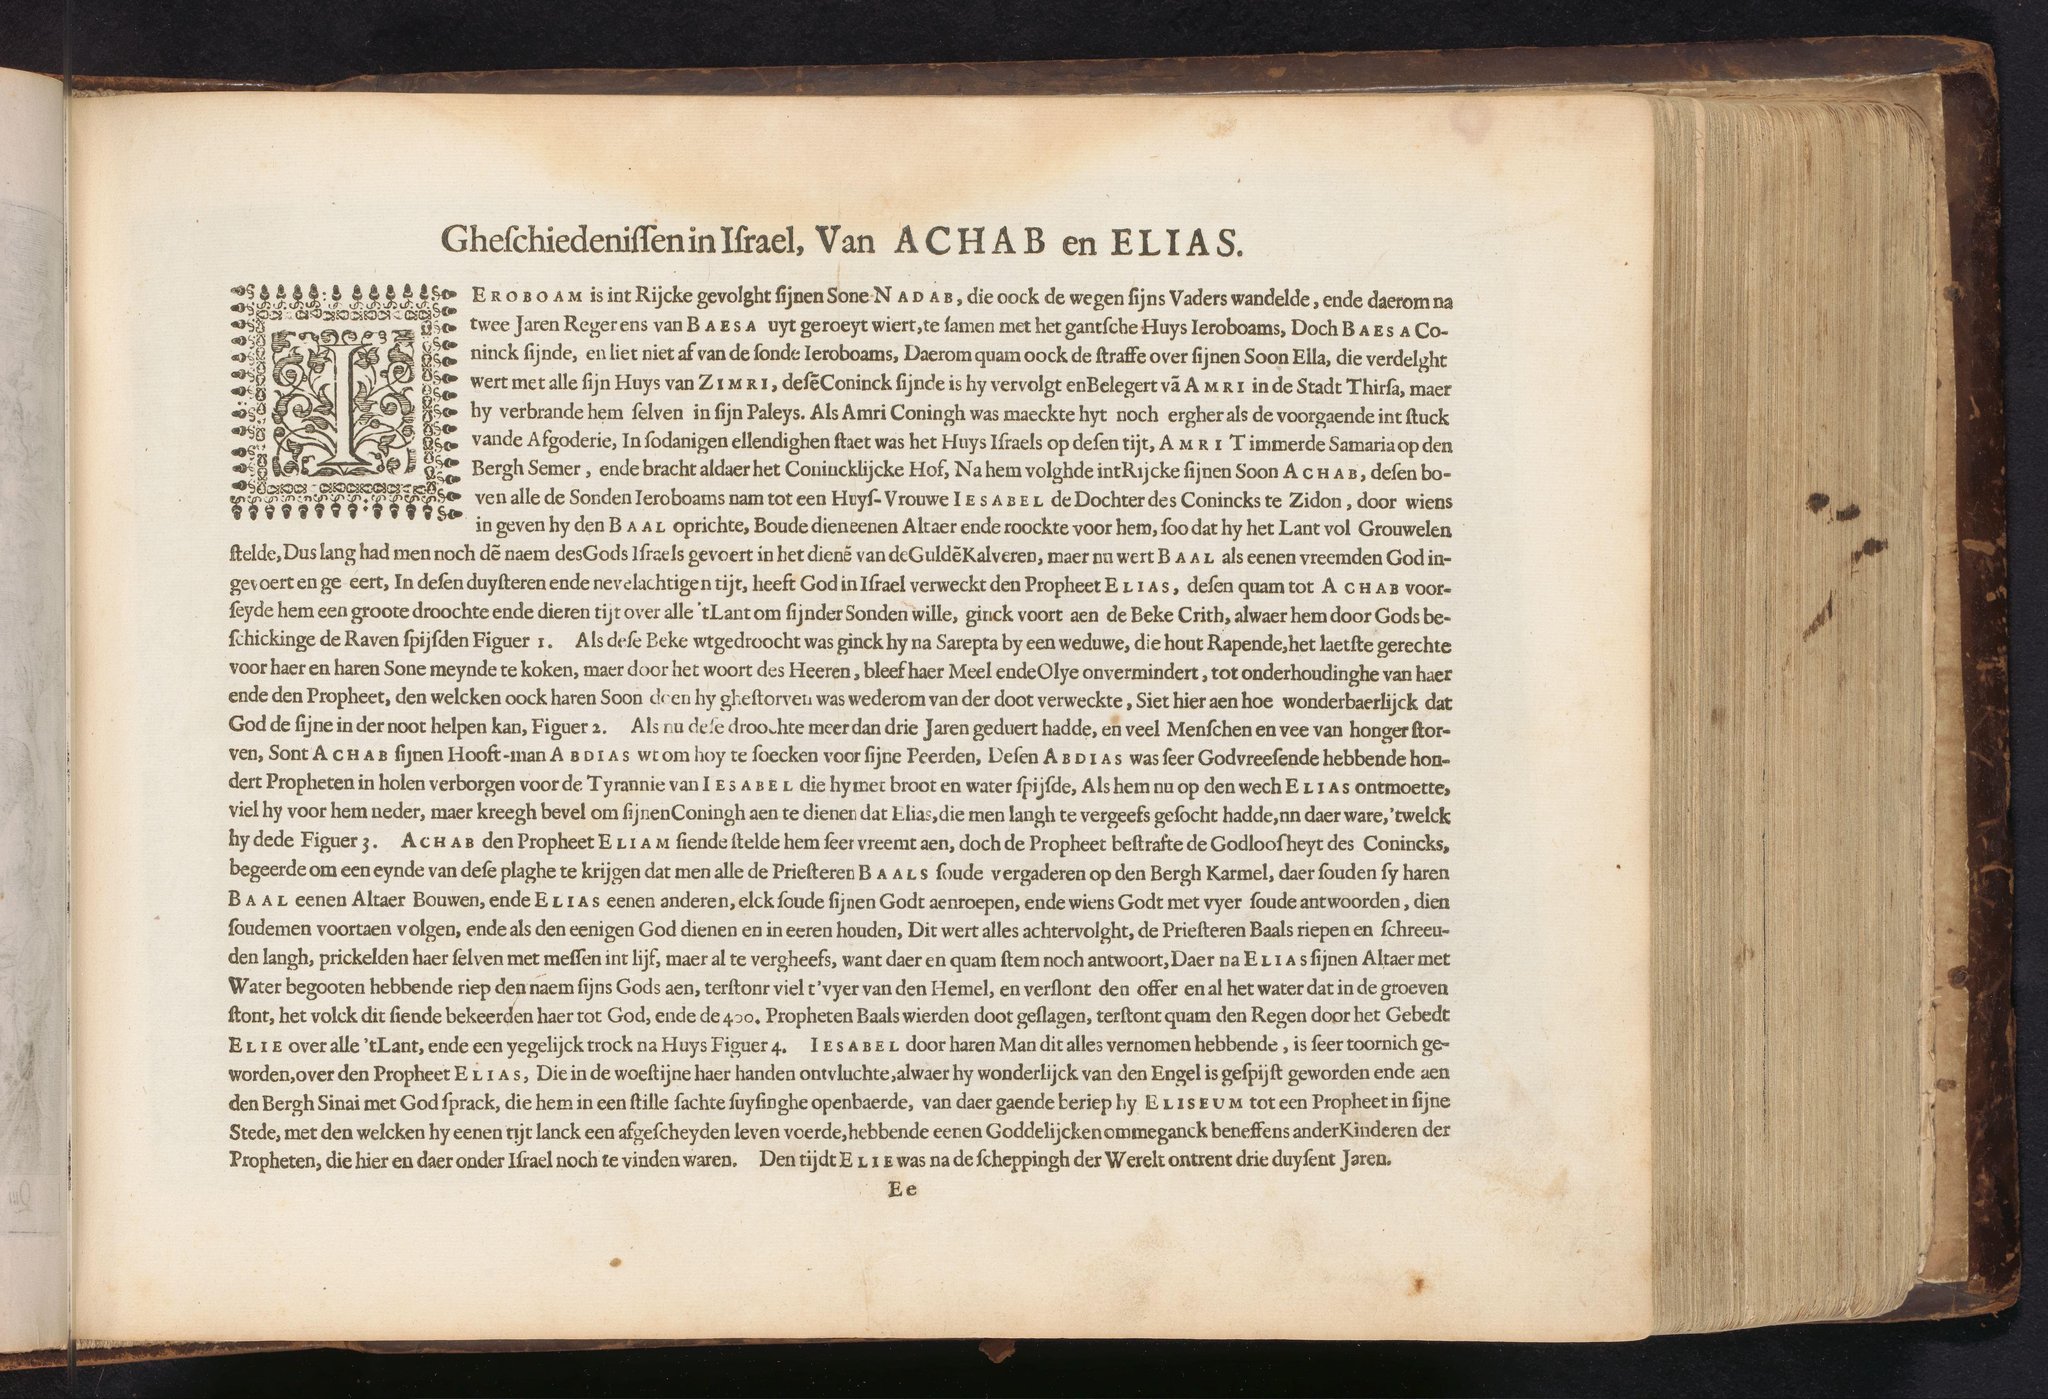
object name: text sheet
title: Gheschiedenissen in Israel, Van Achab en Elias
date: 1646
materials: paper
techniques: letterpress printing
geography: alkmaar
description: Tekstblad bij een serie prenten over de geschiedenis van Achab en Elia. Linksboven initiaal I. Dit blad maakt deel uit van een album.